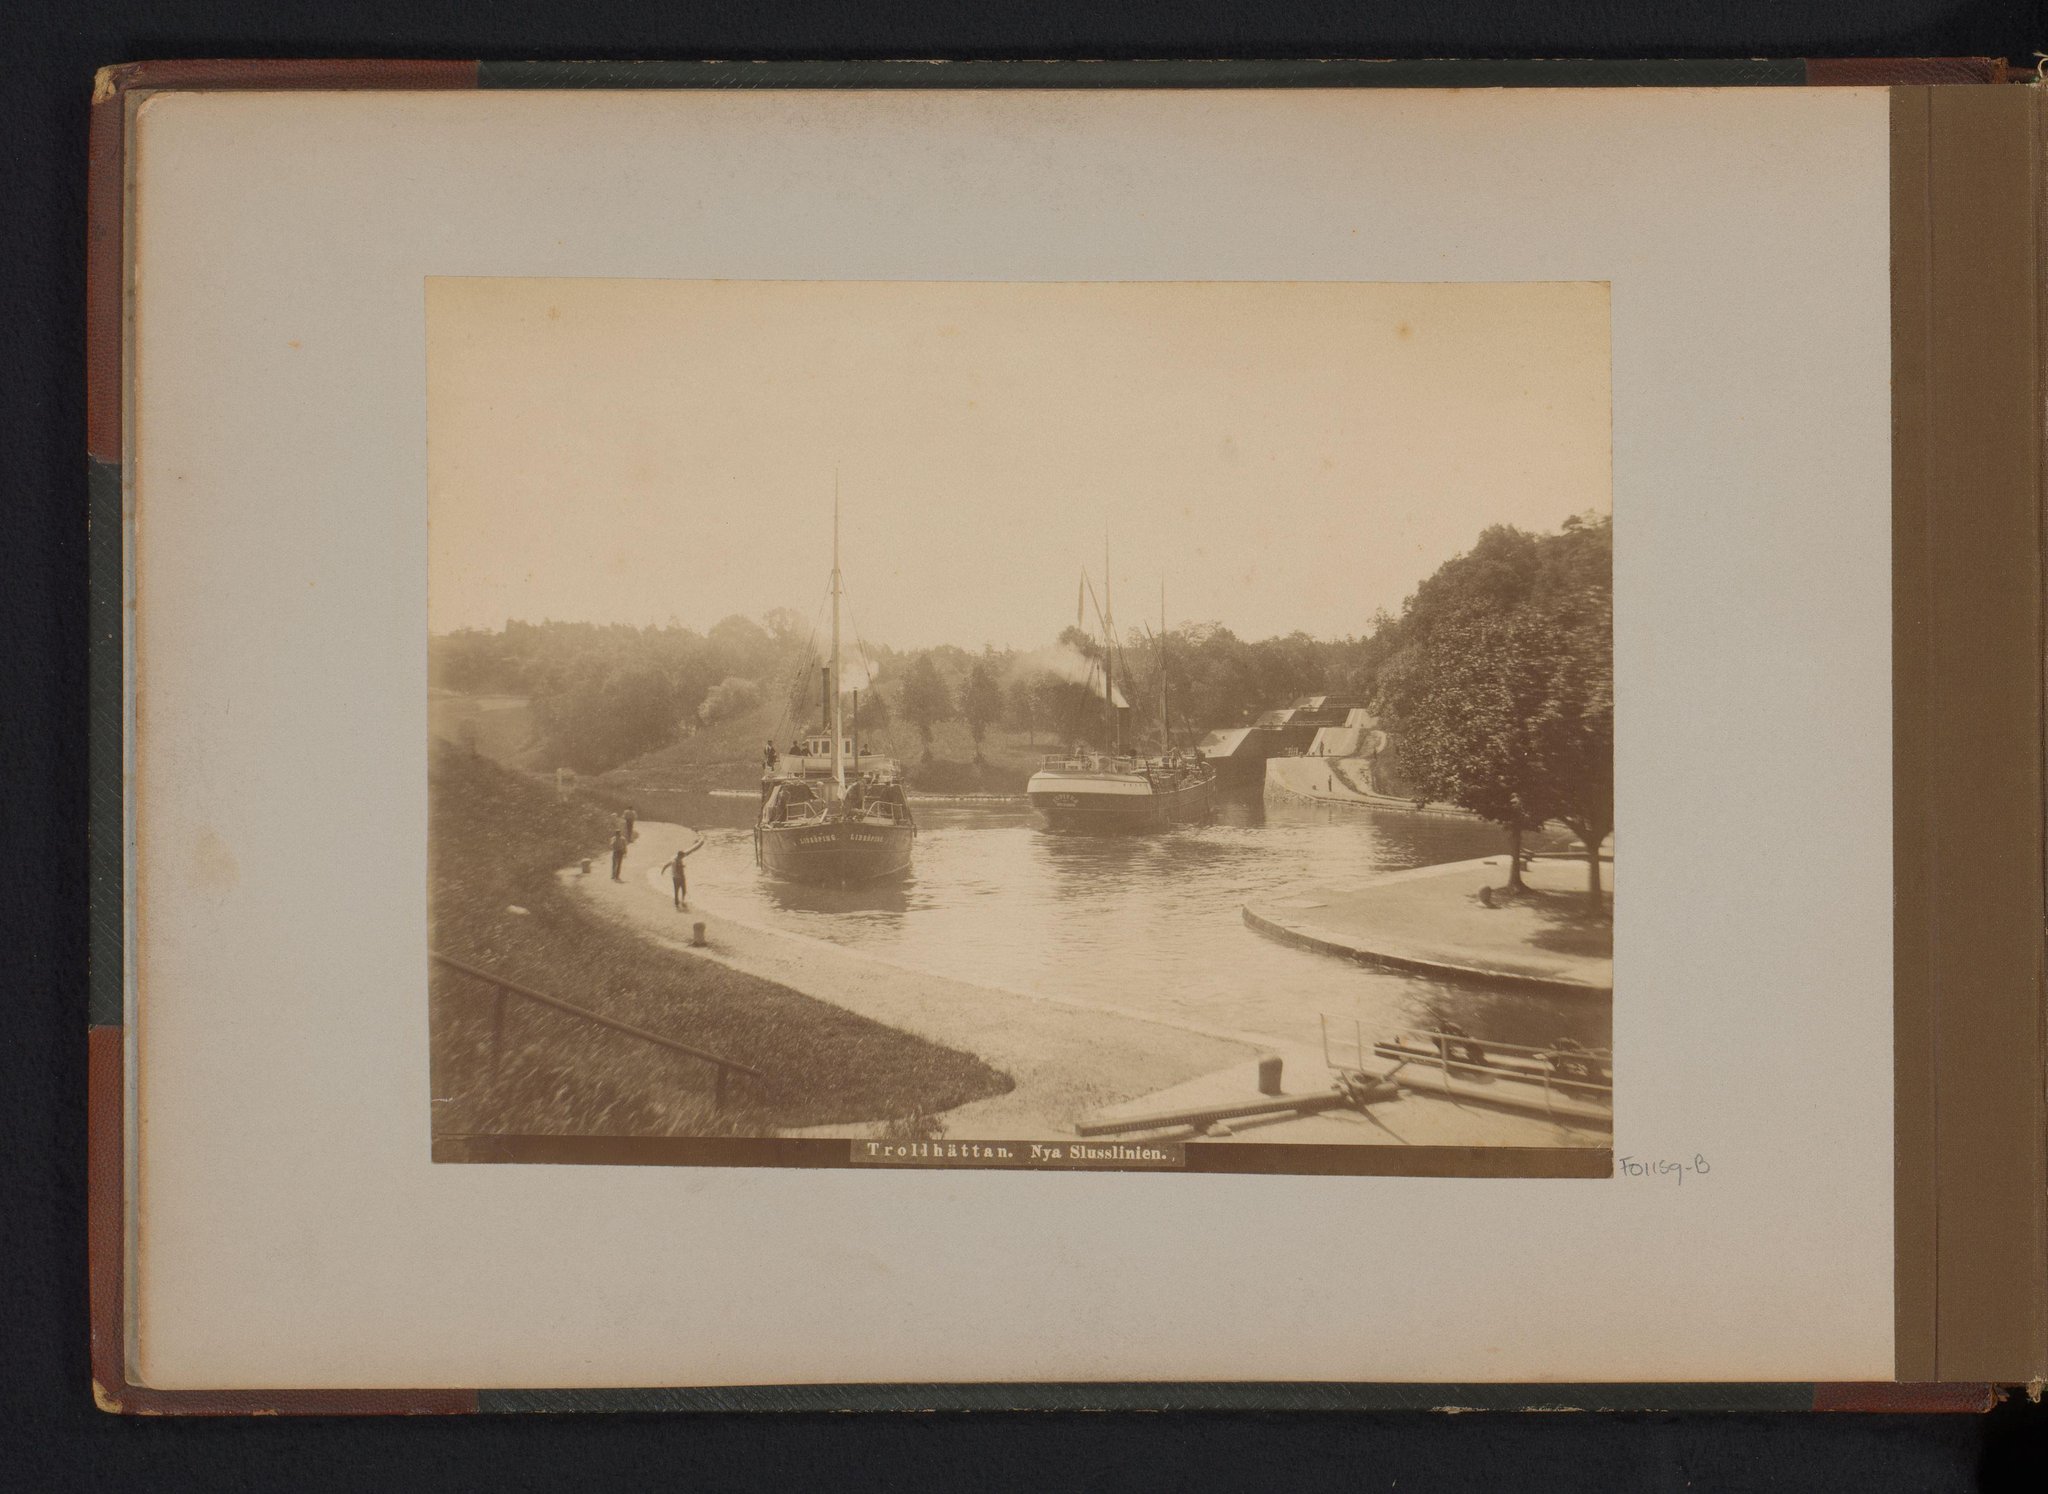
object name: photograph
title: Sluizen met twee boten, de Lidköping en de Jupiter, in Trollhättan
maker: Anonymous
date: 1880-1900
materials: photographic support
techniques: albumen print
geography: trollhättan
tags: sluice, weir, ships (in general)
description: Onderdeel van Reisalbum met opnames van bezienswaardigheden in Zweden, Noorwegen, Denemarken, Beieren, Milaan en Parijs.